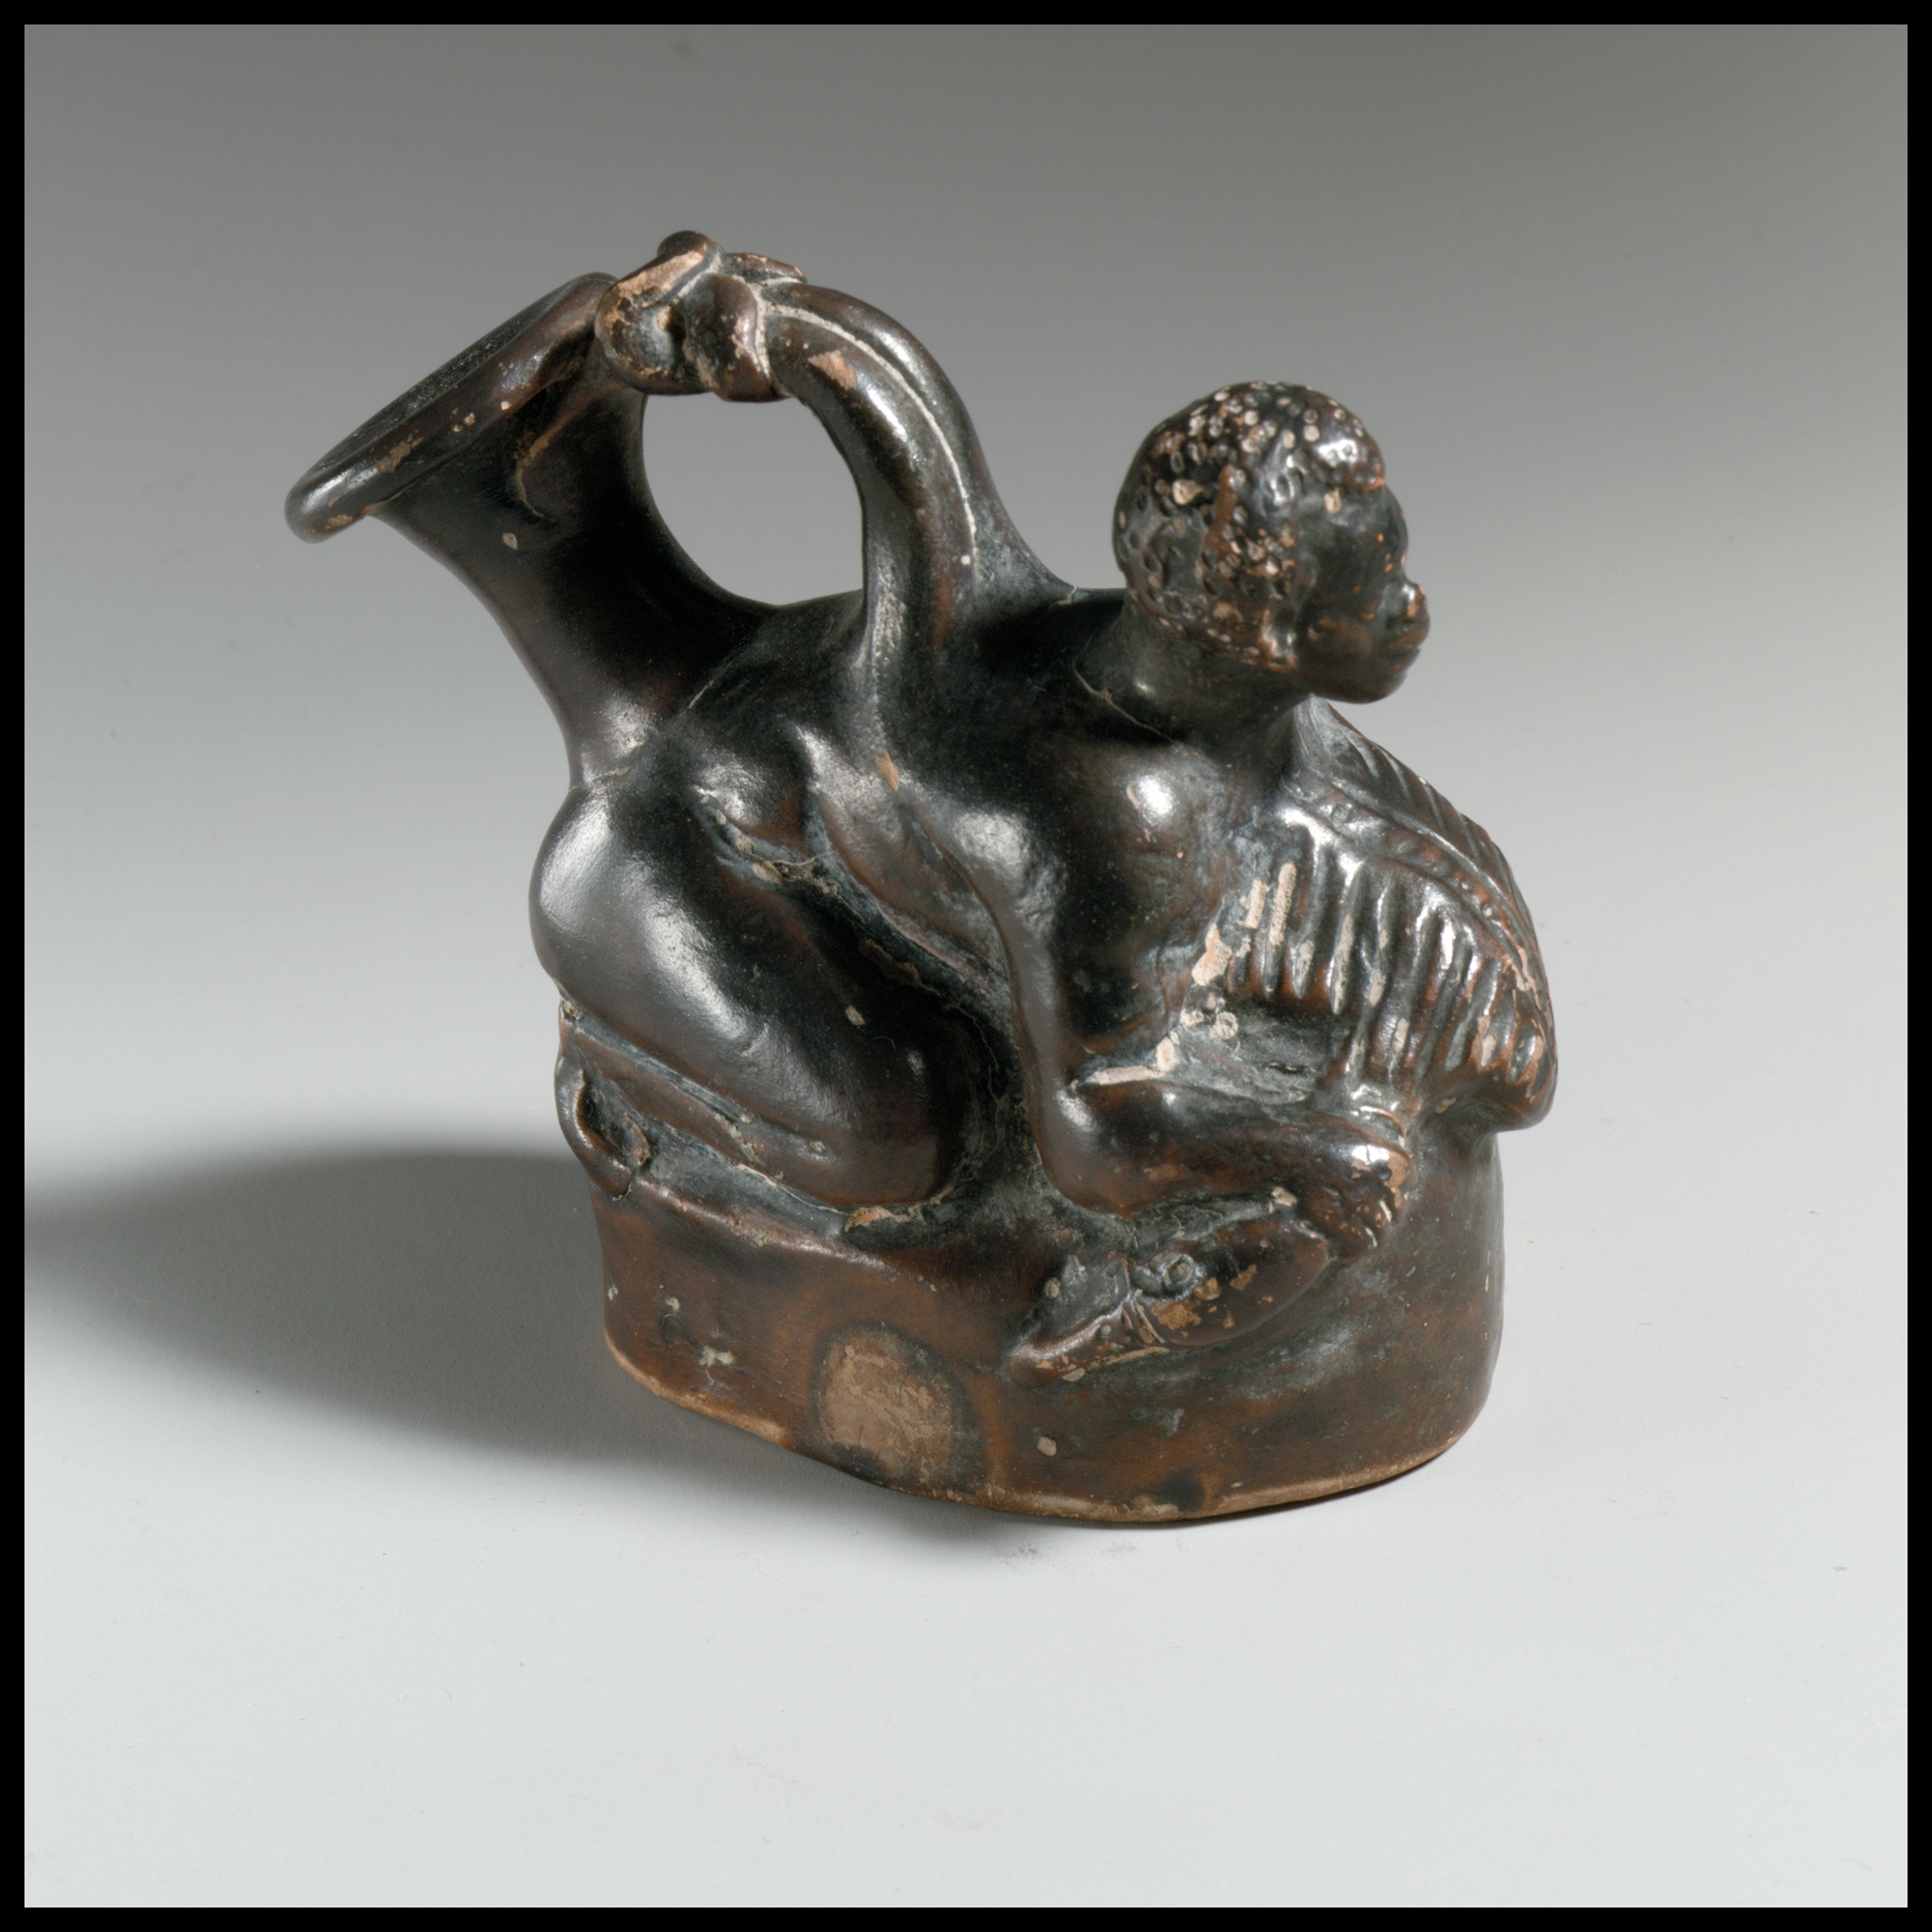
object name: askos in the form of a black youth seizing a duck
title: Terracotta askos (flask with a spout and handle)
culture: greek or south italian or campanian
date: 400-301 BCE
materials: terracotta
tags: boys